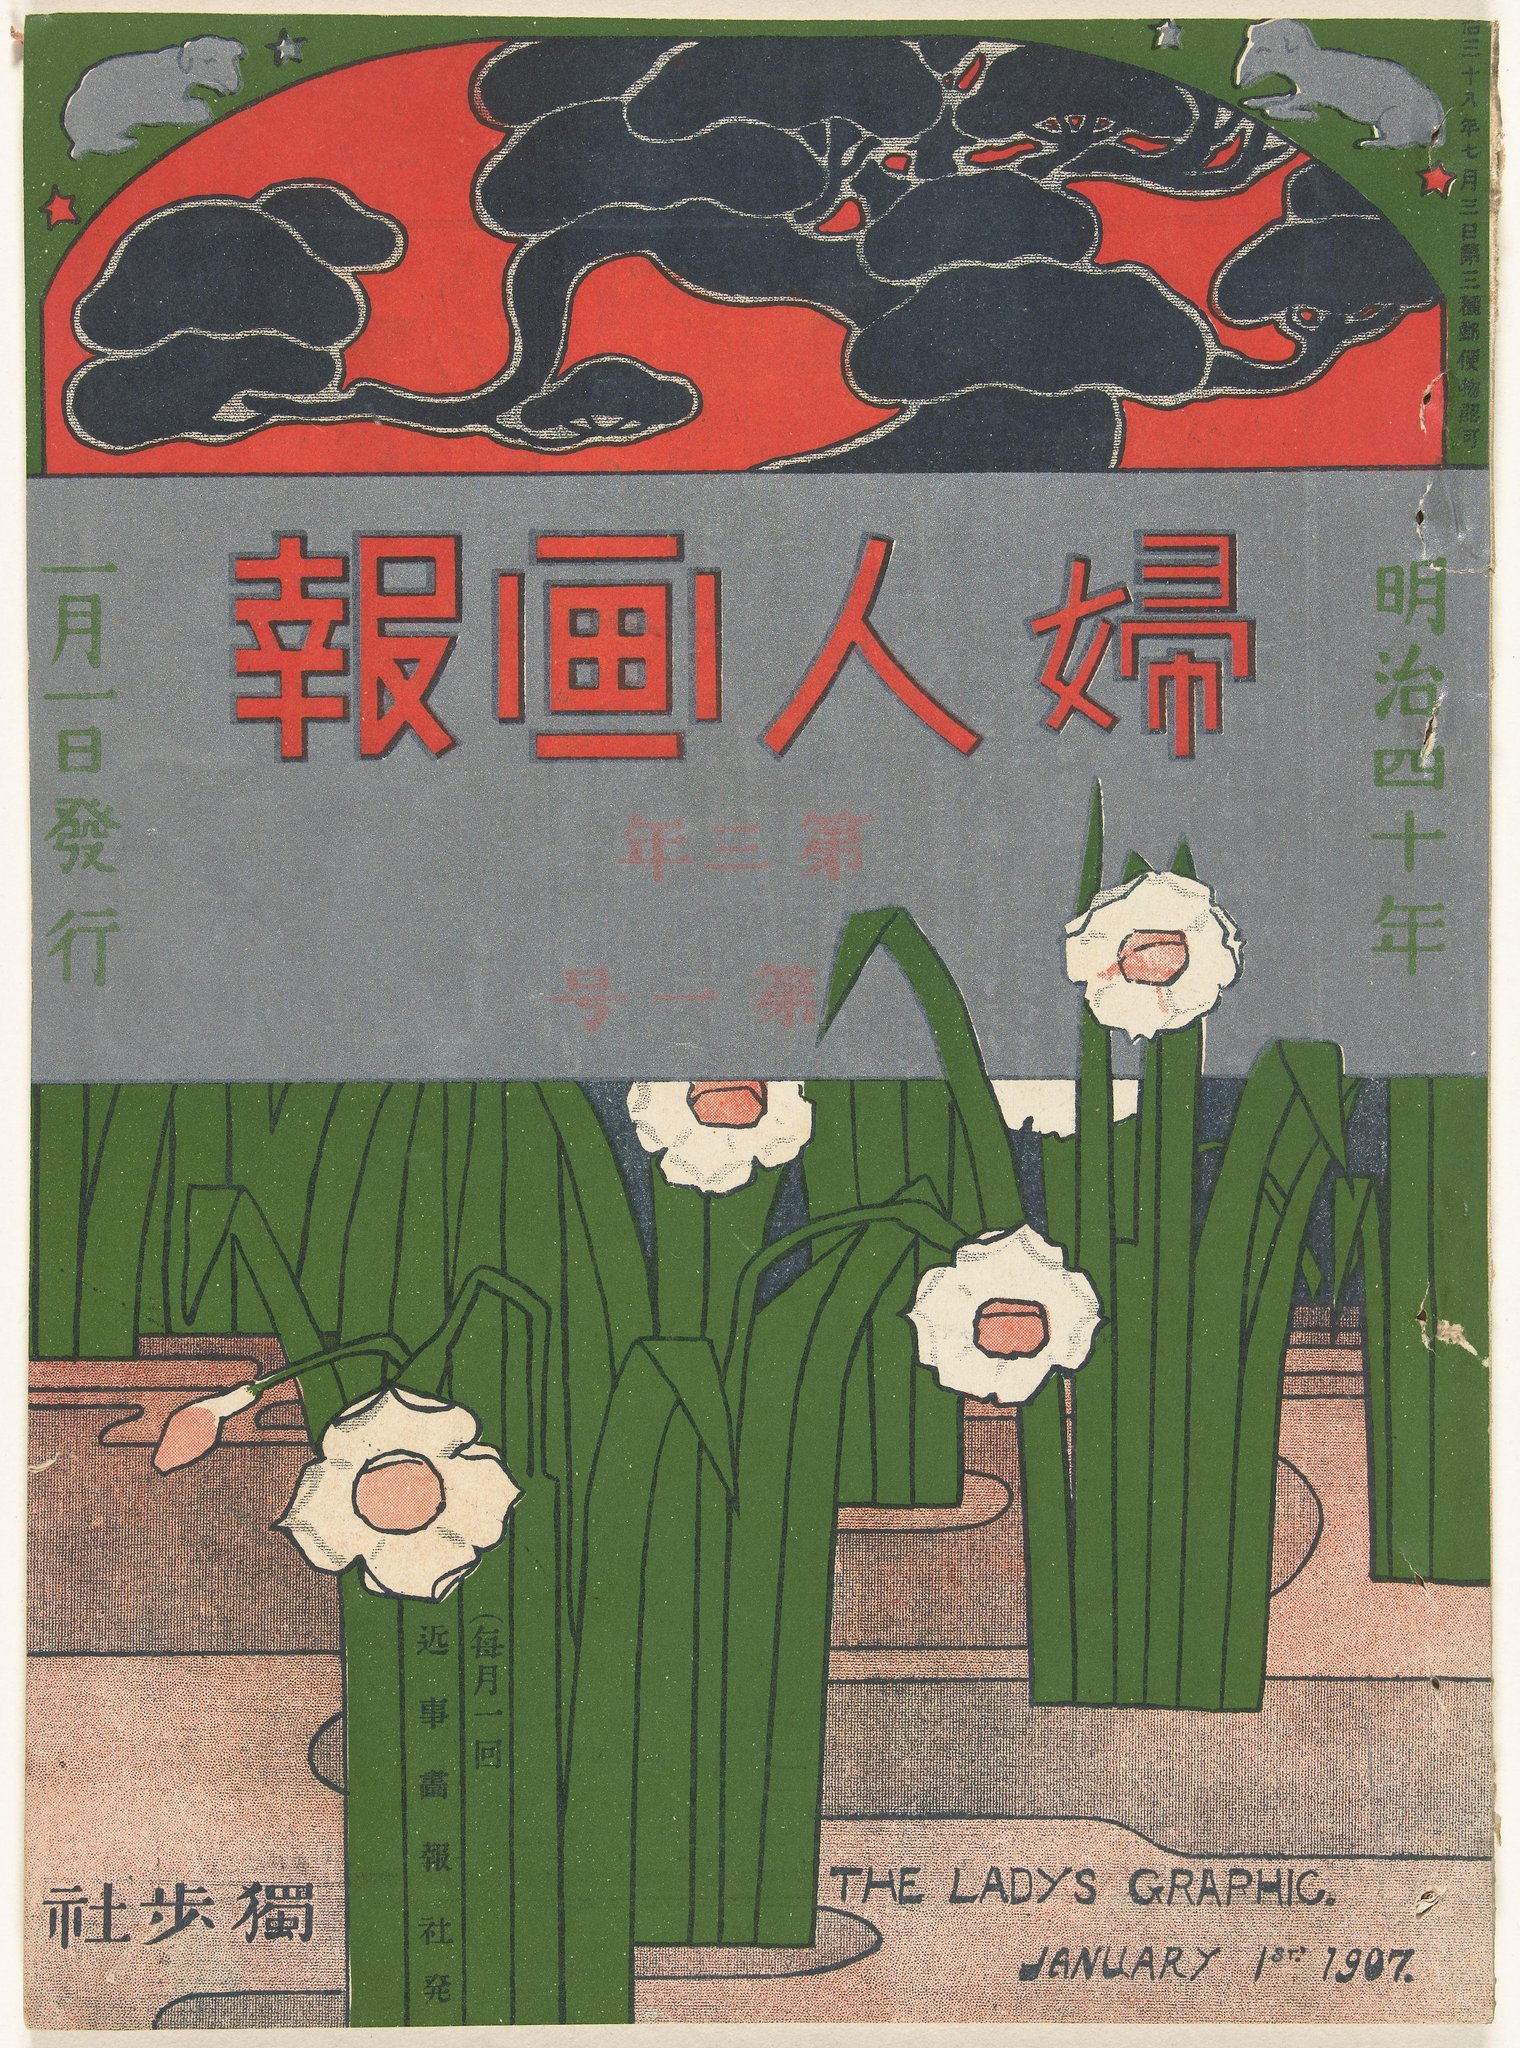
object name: magazine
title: Januari 1907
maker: mitsutani kunishiro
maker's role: designer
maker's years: 1874-1936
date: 1907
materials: paper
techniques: letterpress printing, lithograph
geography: japan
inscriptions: date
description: Nummer 1 van de derde jaargang (januari 1907) van het tijdschrift Fujin gaho: kaft met bloeiende witte waterbloemen, titel in rood tegen zilverkleurige achtergrond; binnenin, uitvouwbare frontispies waarop landschap.